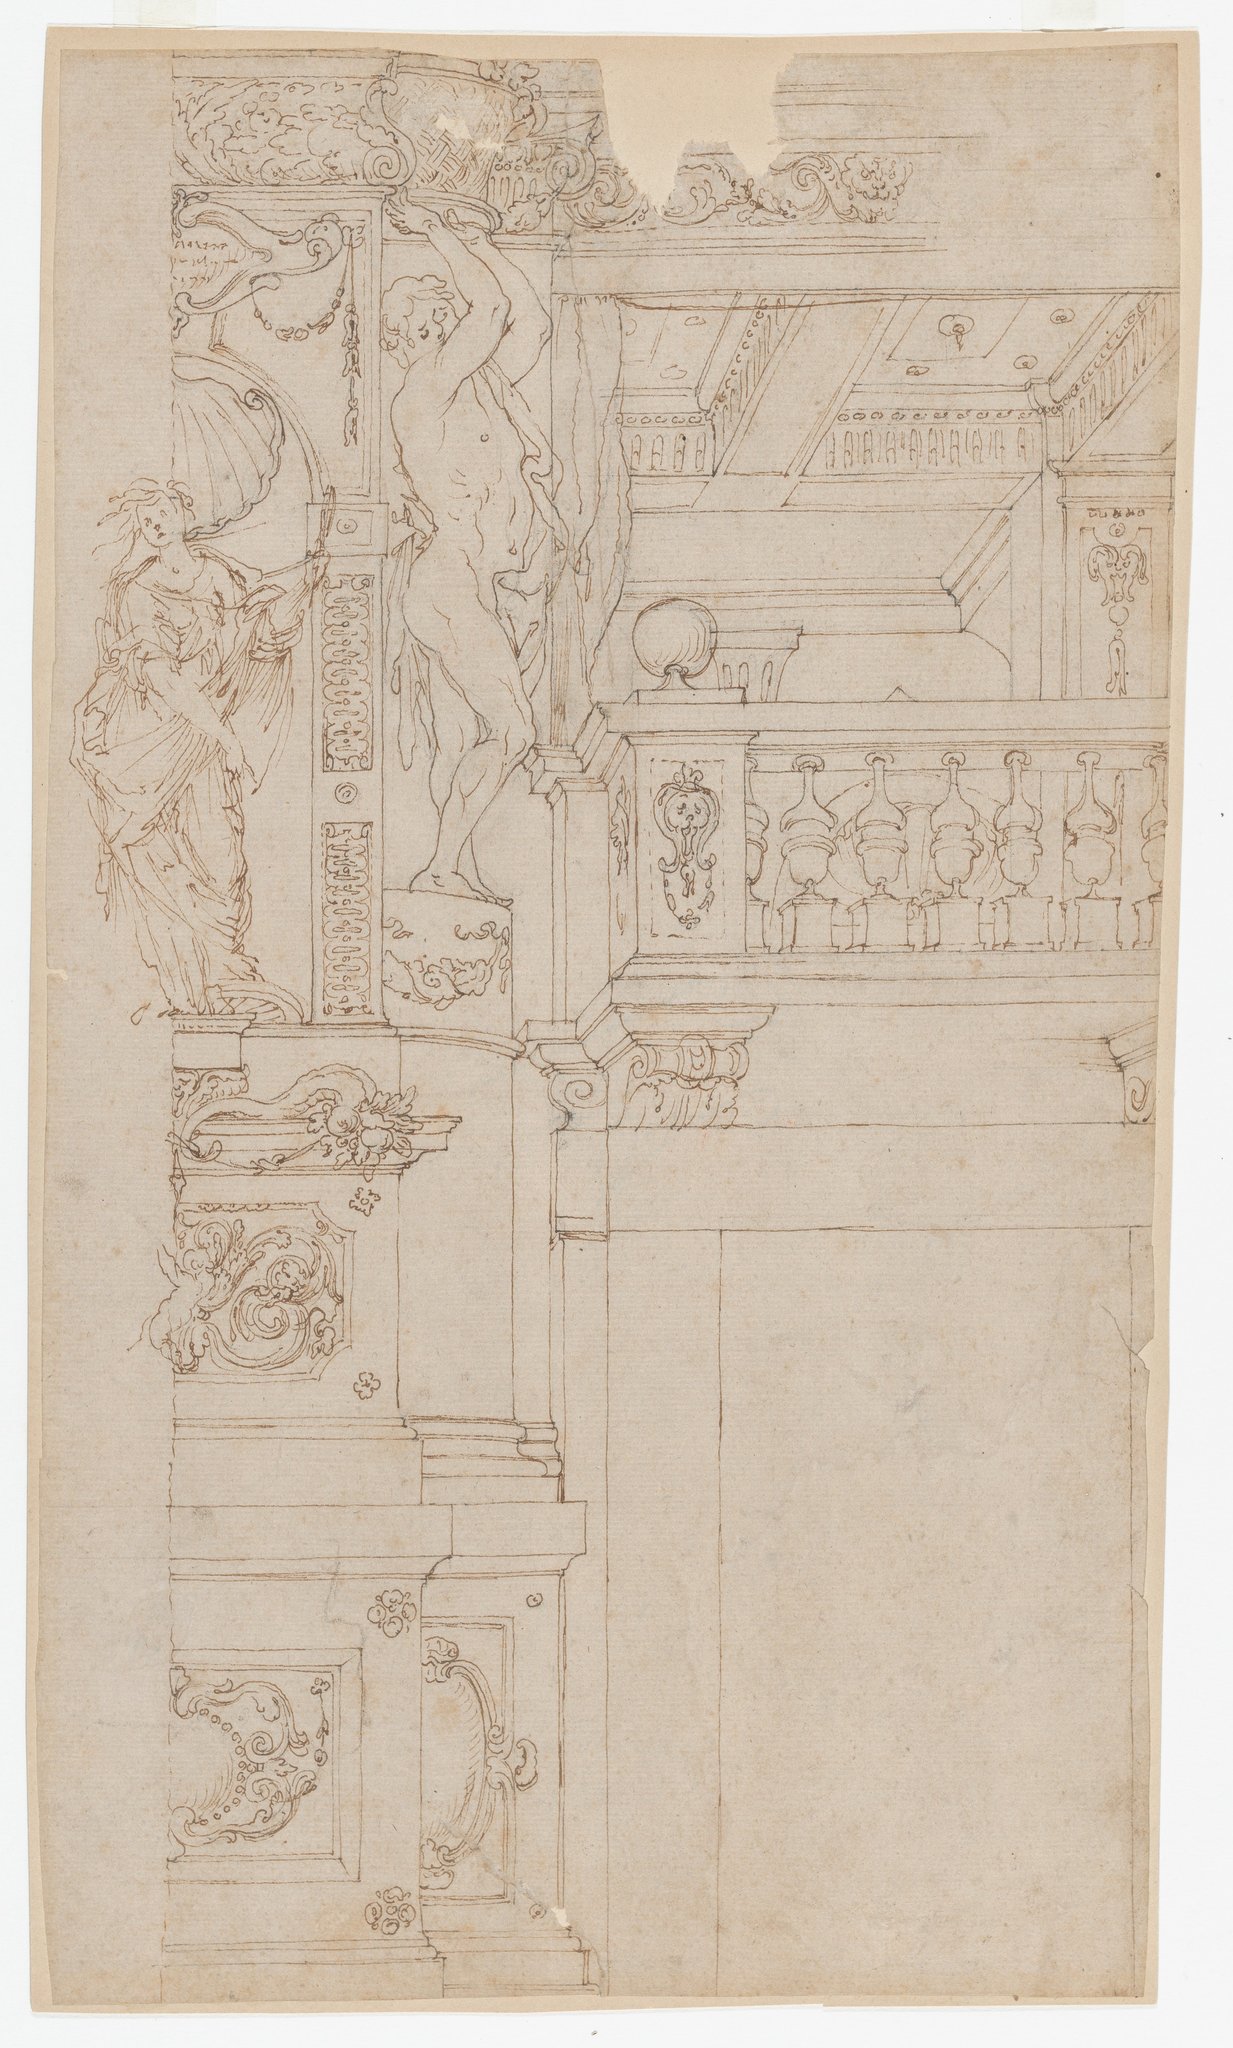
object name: drawing ornament architecture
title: Studies for the trompe-l’oeil decorations of Palazzo Ducale (Palazzo Pitti), Florence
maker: agostino (stanzani) mitelli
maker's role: artist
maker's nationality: italian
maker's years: 1609-1660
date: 1636-1641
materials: chalk, ink, watercolor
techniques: pen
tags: architecture,male nudes,women